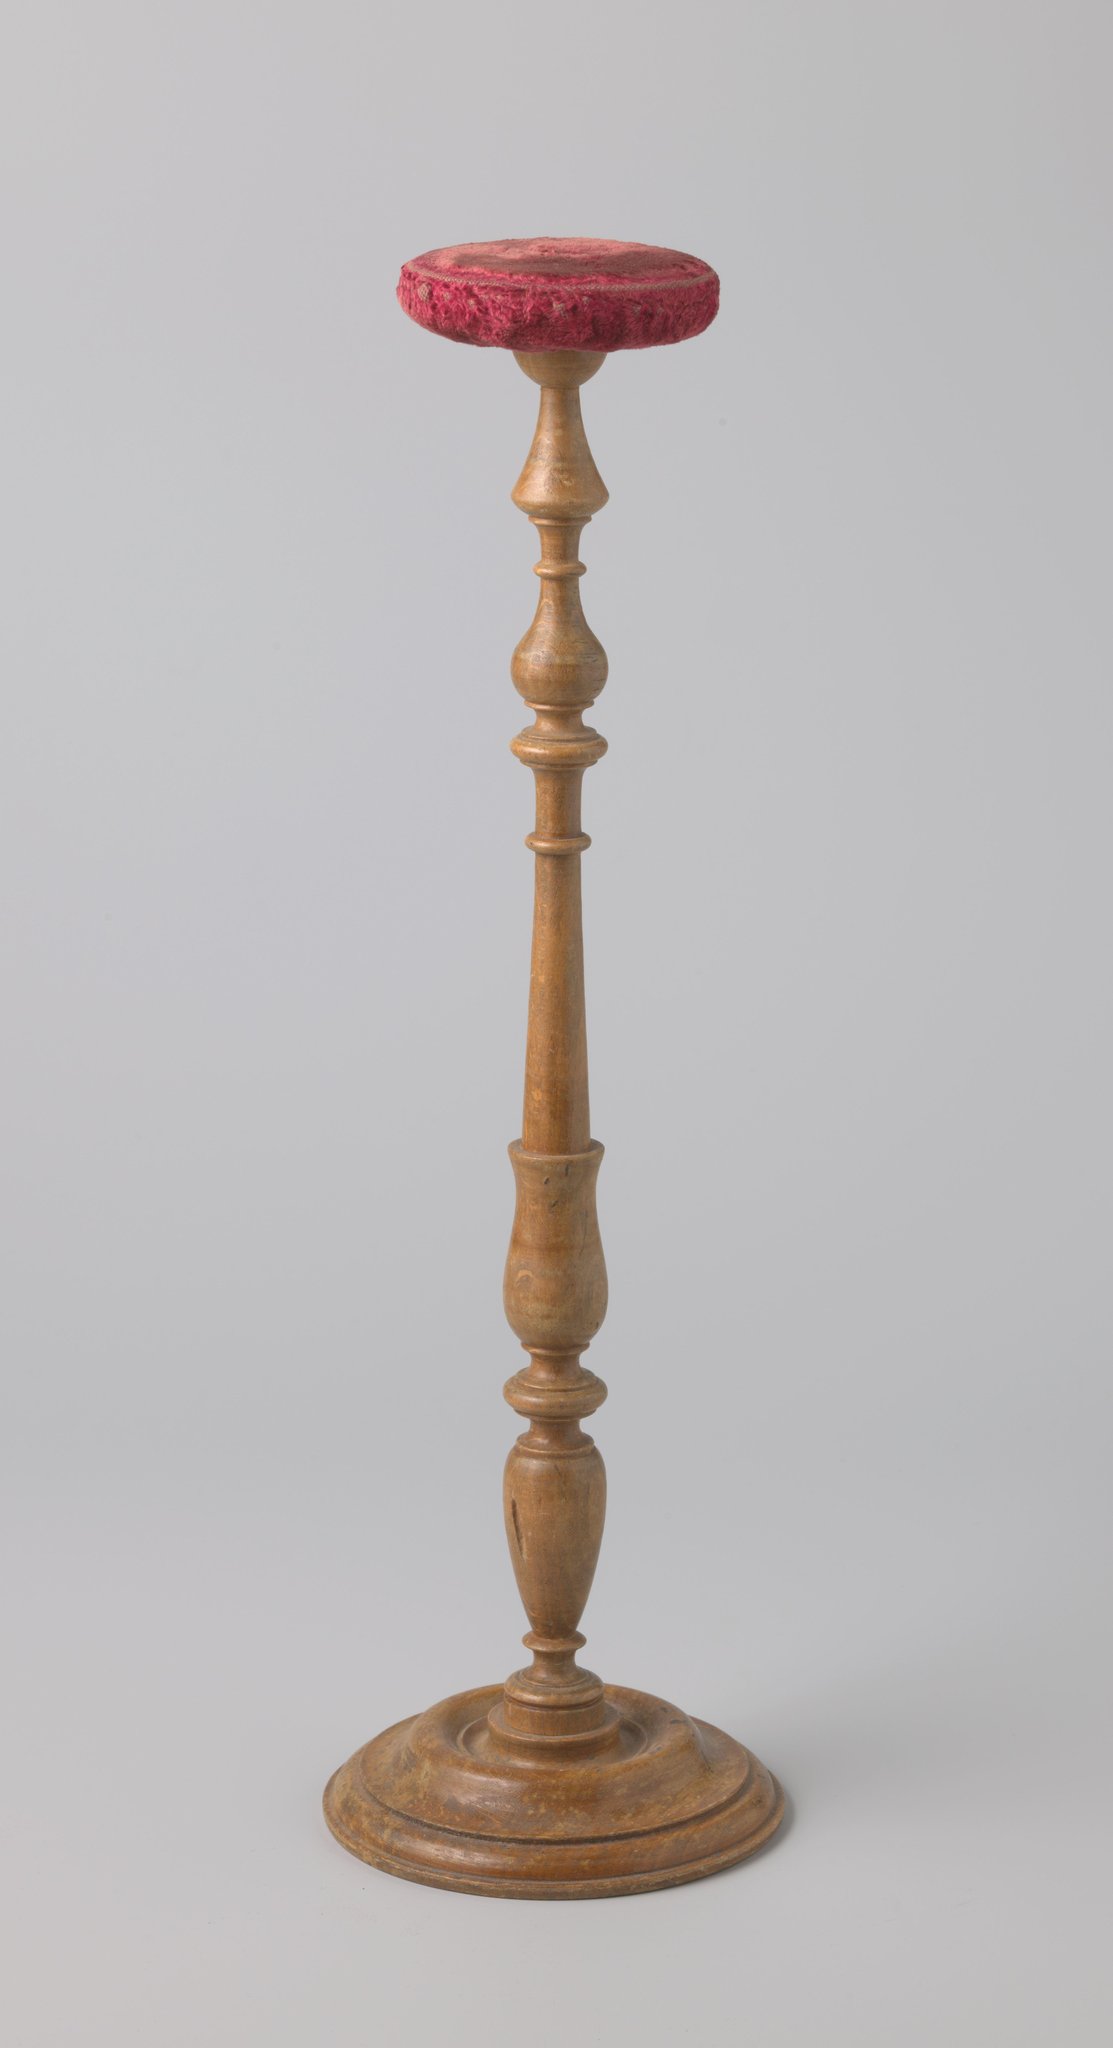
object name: hat stand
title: Hoedenstandaard van gedraaid beukenhout, op een ronde voet staat een bewerkte stam waarop een ronde, met roze fluweel beklede steun zit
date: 1875-1925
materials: wood, velvet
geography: paris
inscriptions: company name: ‘STOCKMAN // PARIS // DEPOSÉ’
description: Hoedenstandaard van gedraaid beukenhout. Op een ronde voet staat een bewerkte stam waarop een ronde, met roze fluweel beklede steun zit. Gemerkt onderop de voet: Stockman Paris.